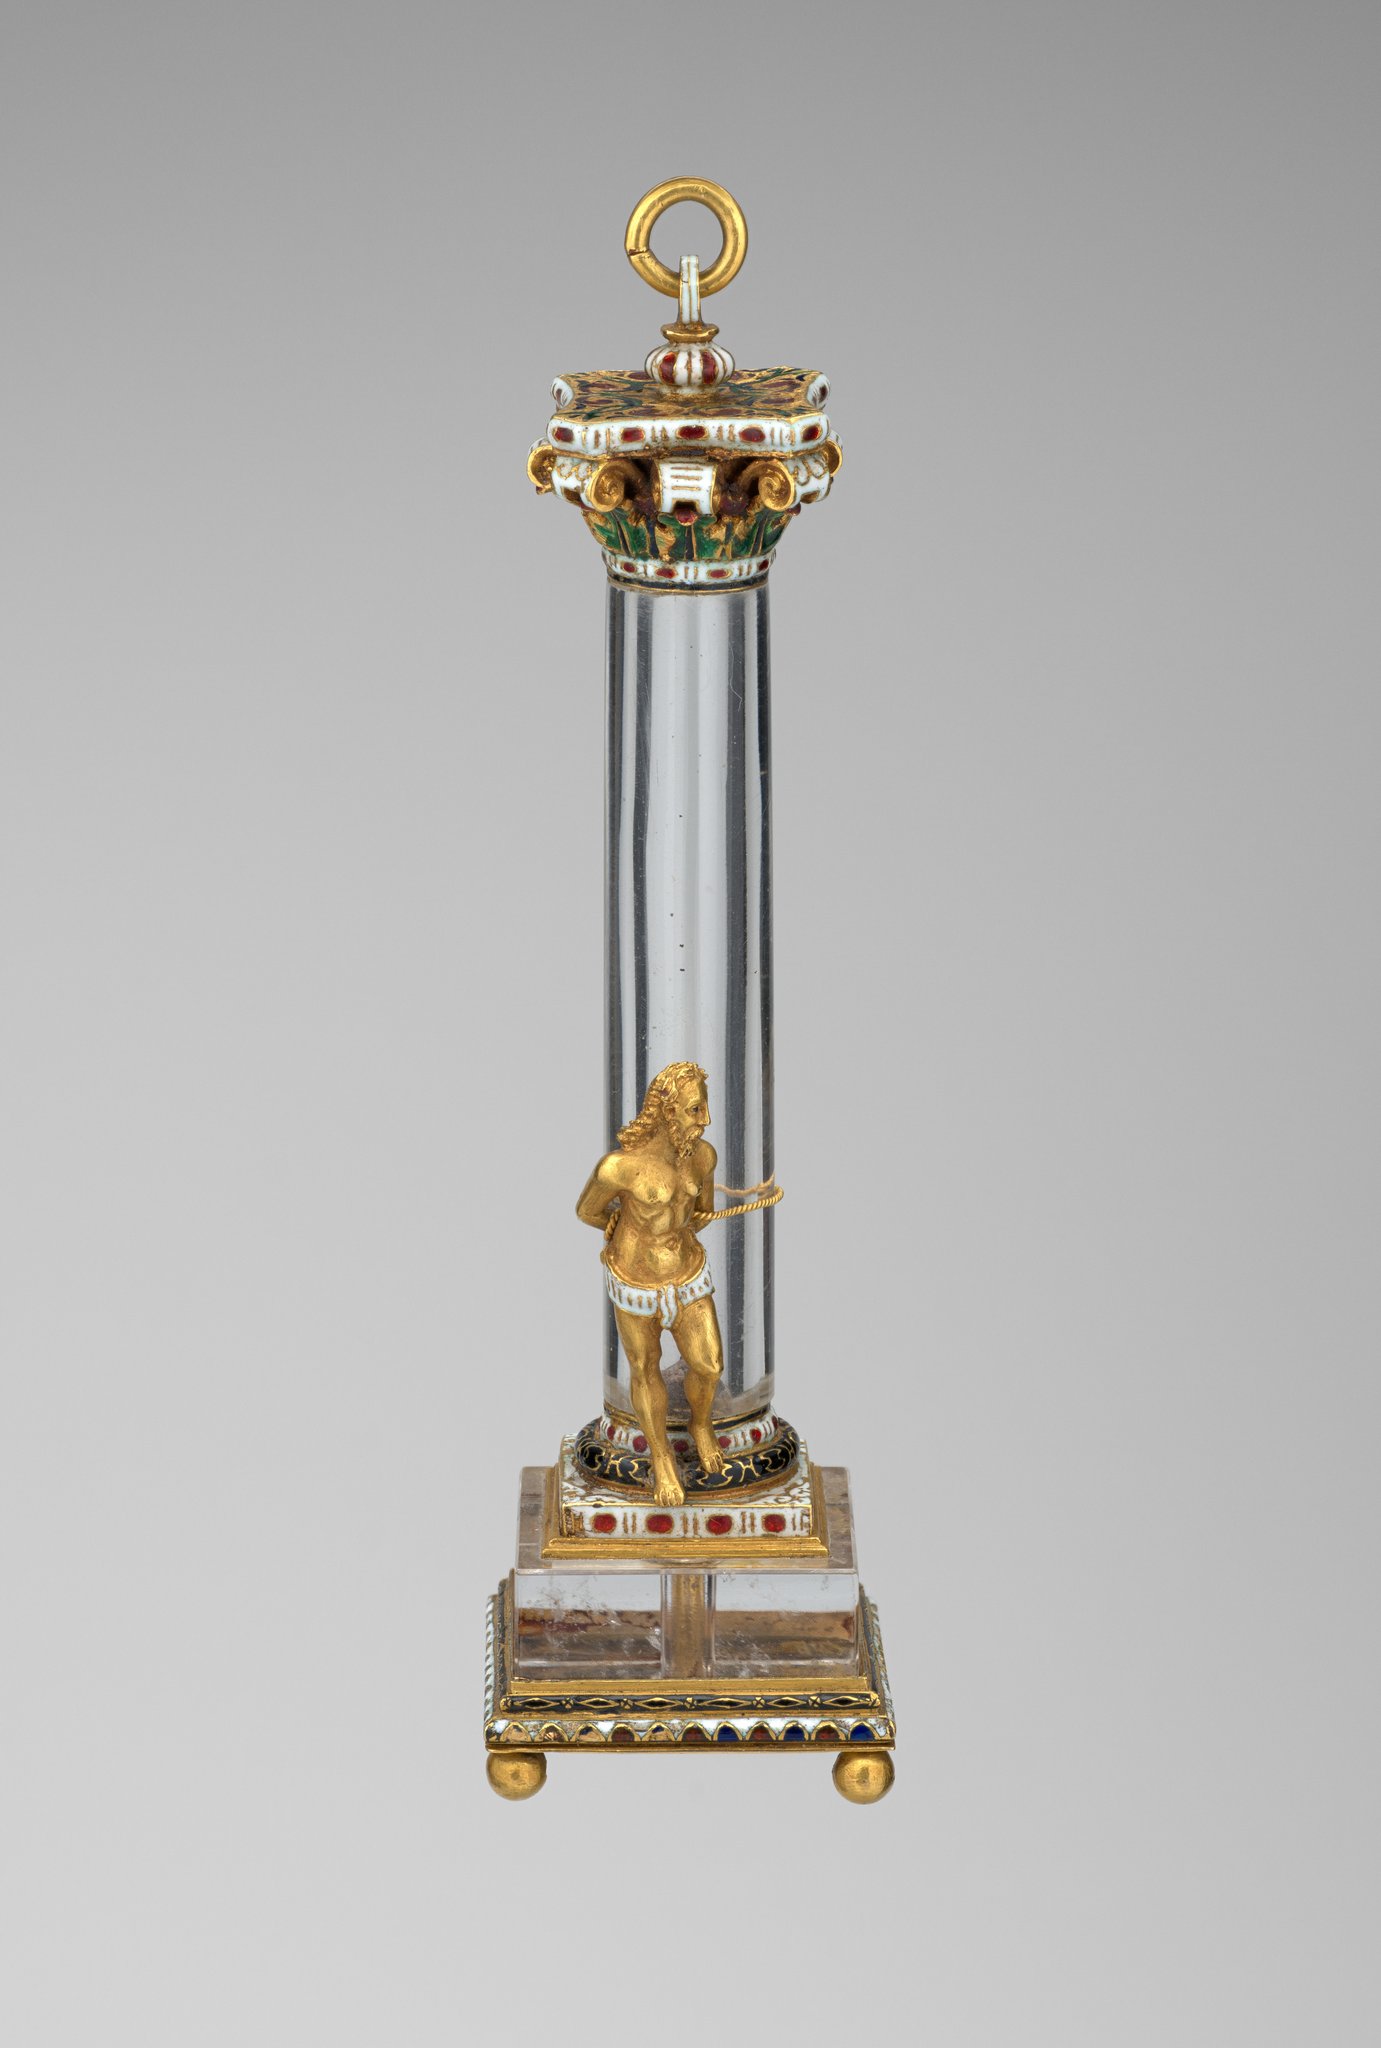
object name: reliquary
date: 1801-1900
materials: enamel, gold, quartz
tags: christ